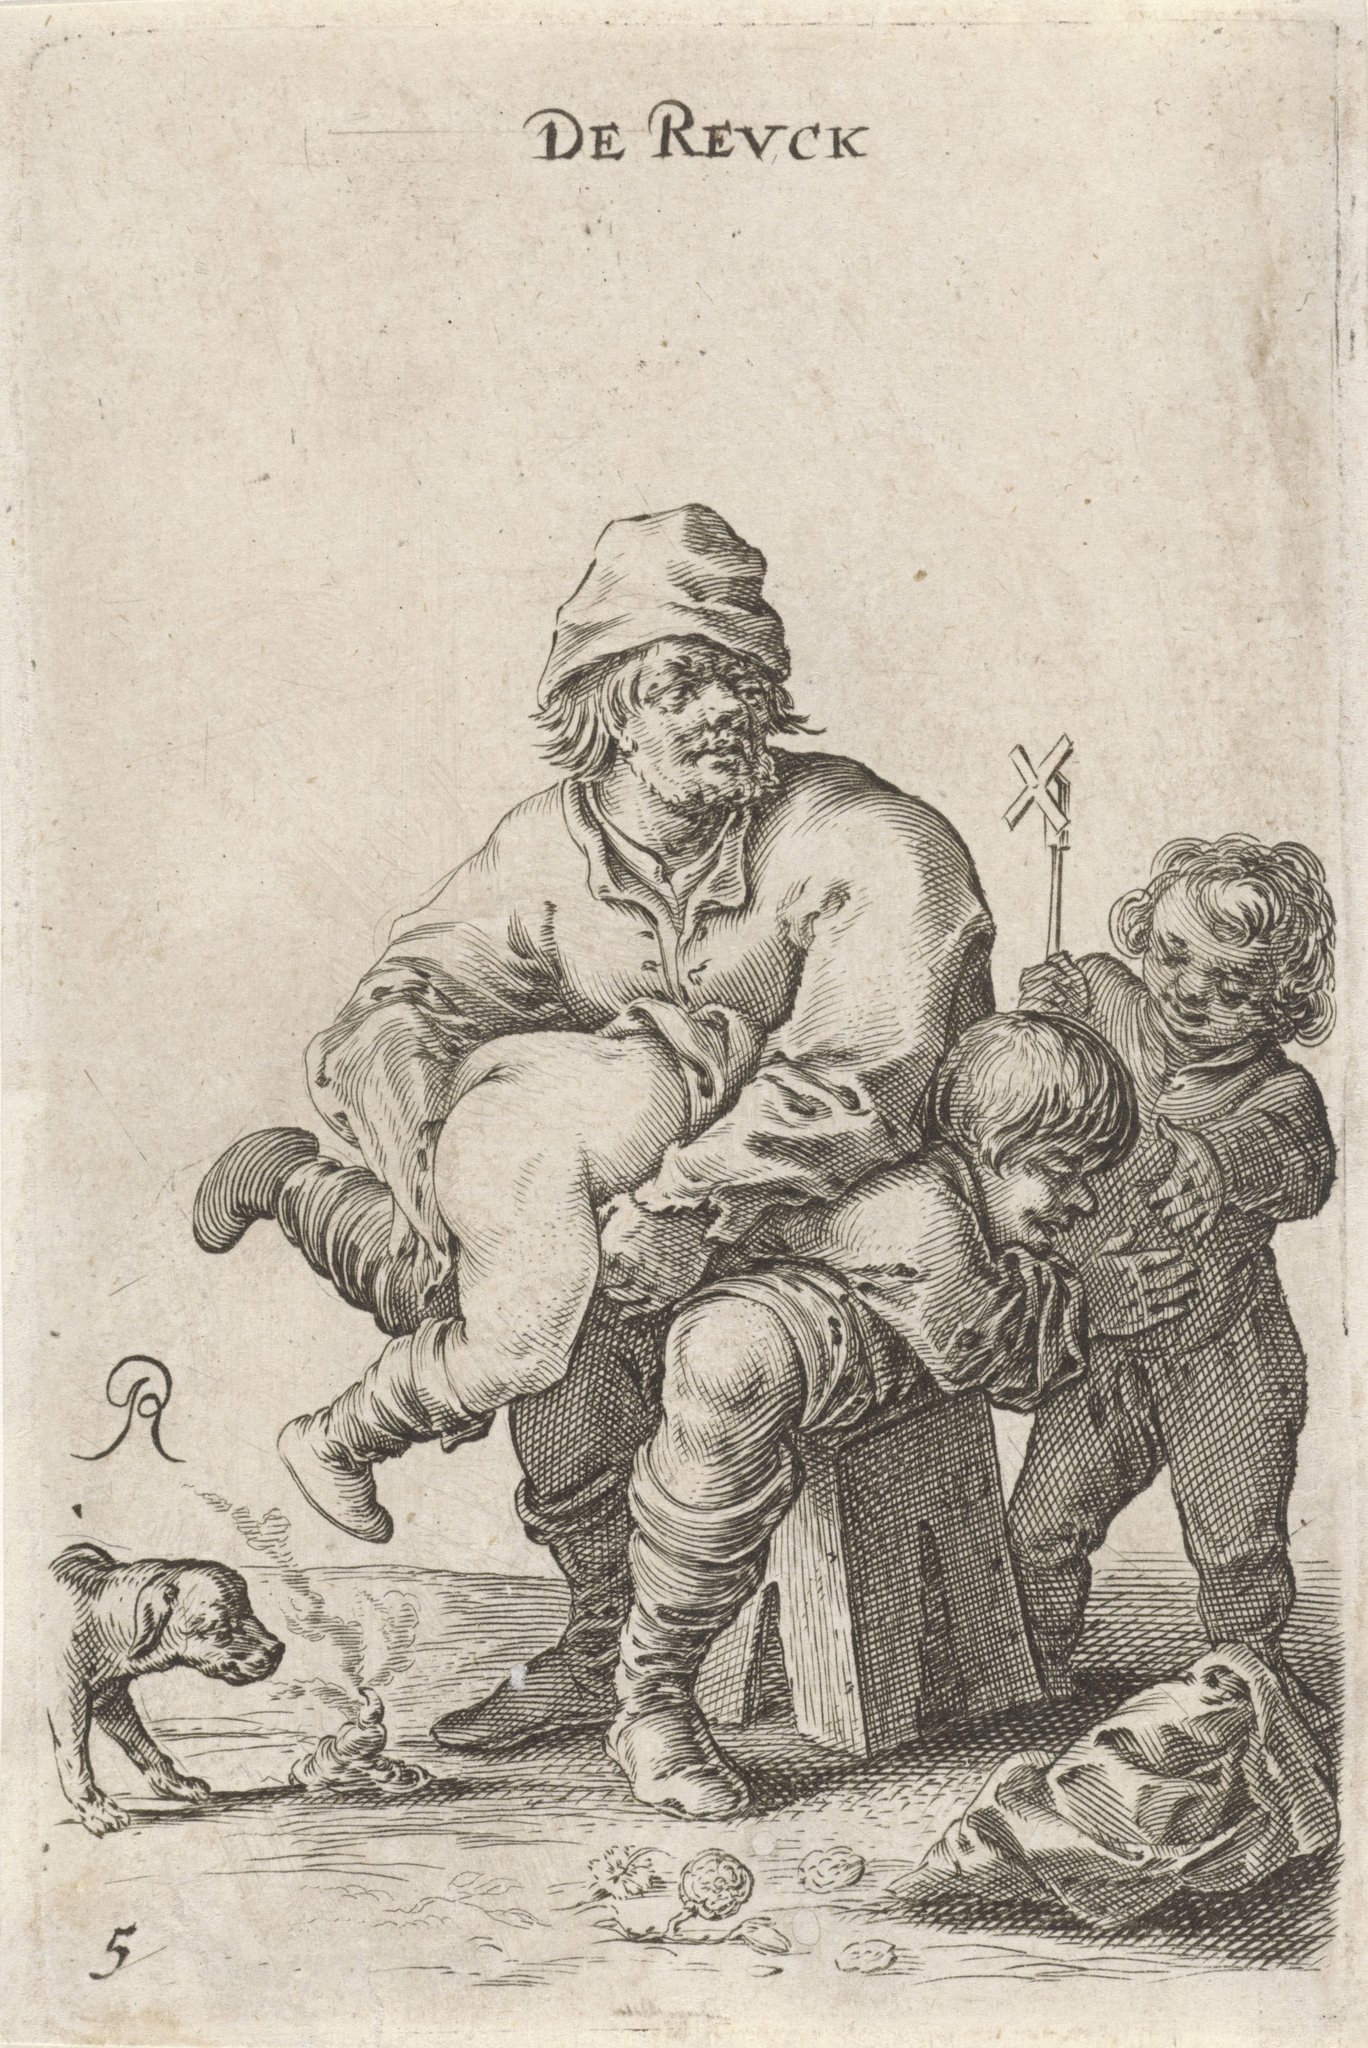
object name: print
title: De Reuck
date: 1638-1665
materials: paper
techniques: engraving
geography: amsterdam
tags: smell, smelling (one of the five senses), hygienic care of children, defecation, dog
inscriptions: collector's mark: Lugt 2228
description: Een man veegt de billen van een kind met een doek schoon. Een tweede kind kijkt toe. Links ruikt een hond aan de uitwerpselen van het kind. De prent maakt deel uit van een zesdelige serie prenten met voorstellingen van de vijf zintuigen (ongenummerde titelprent).